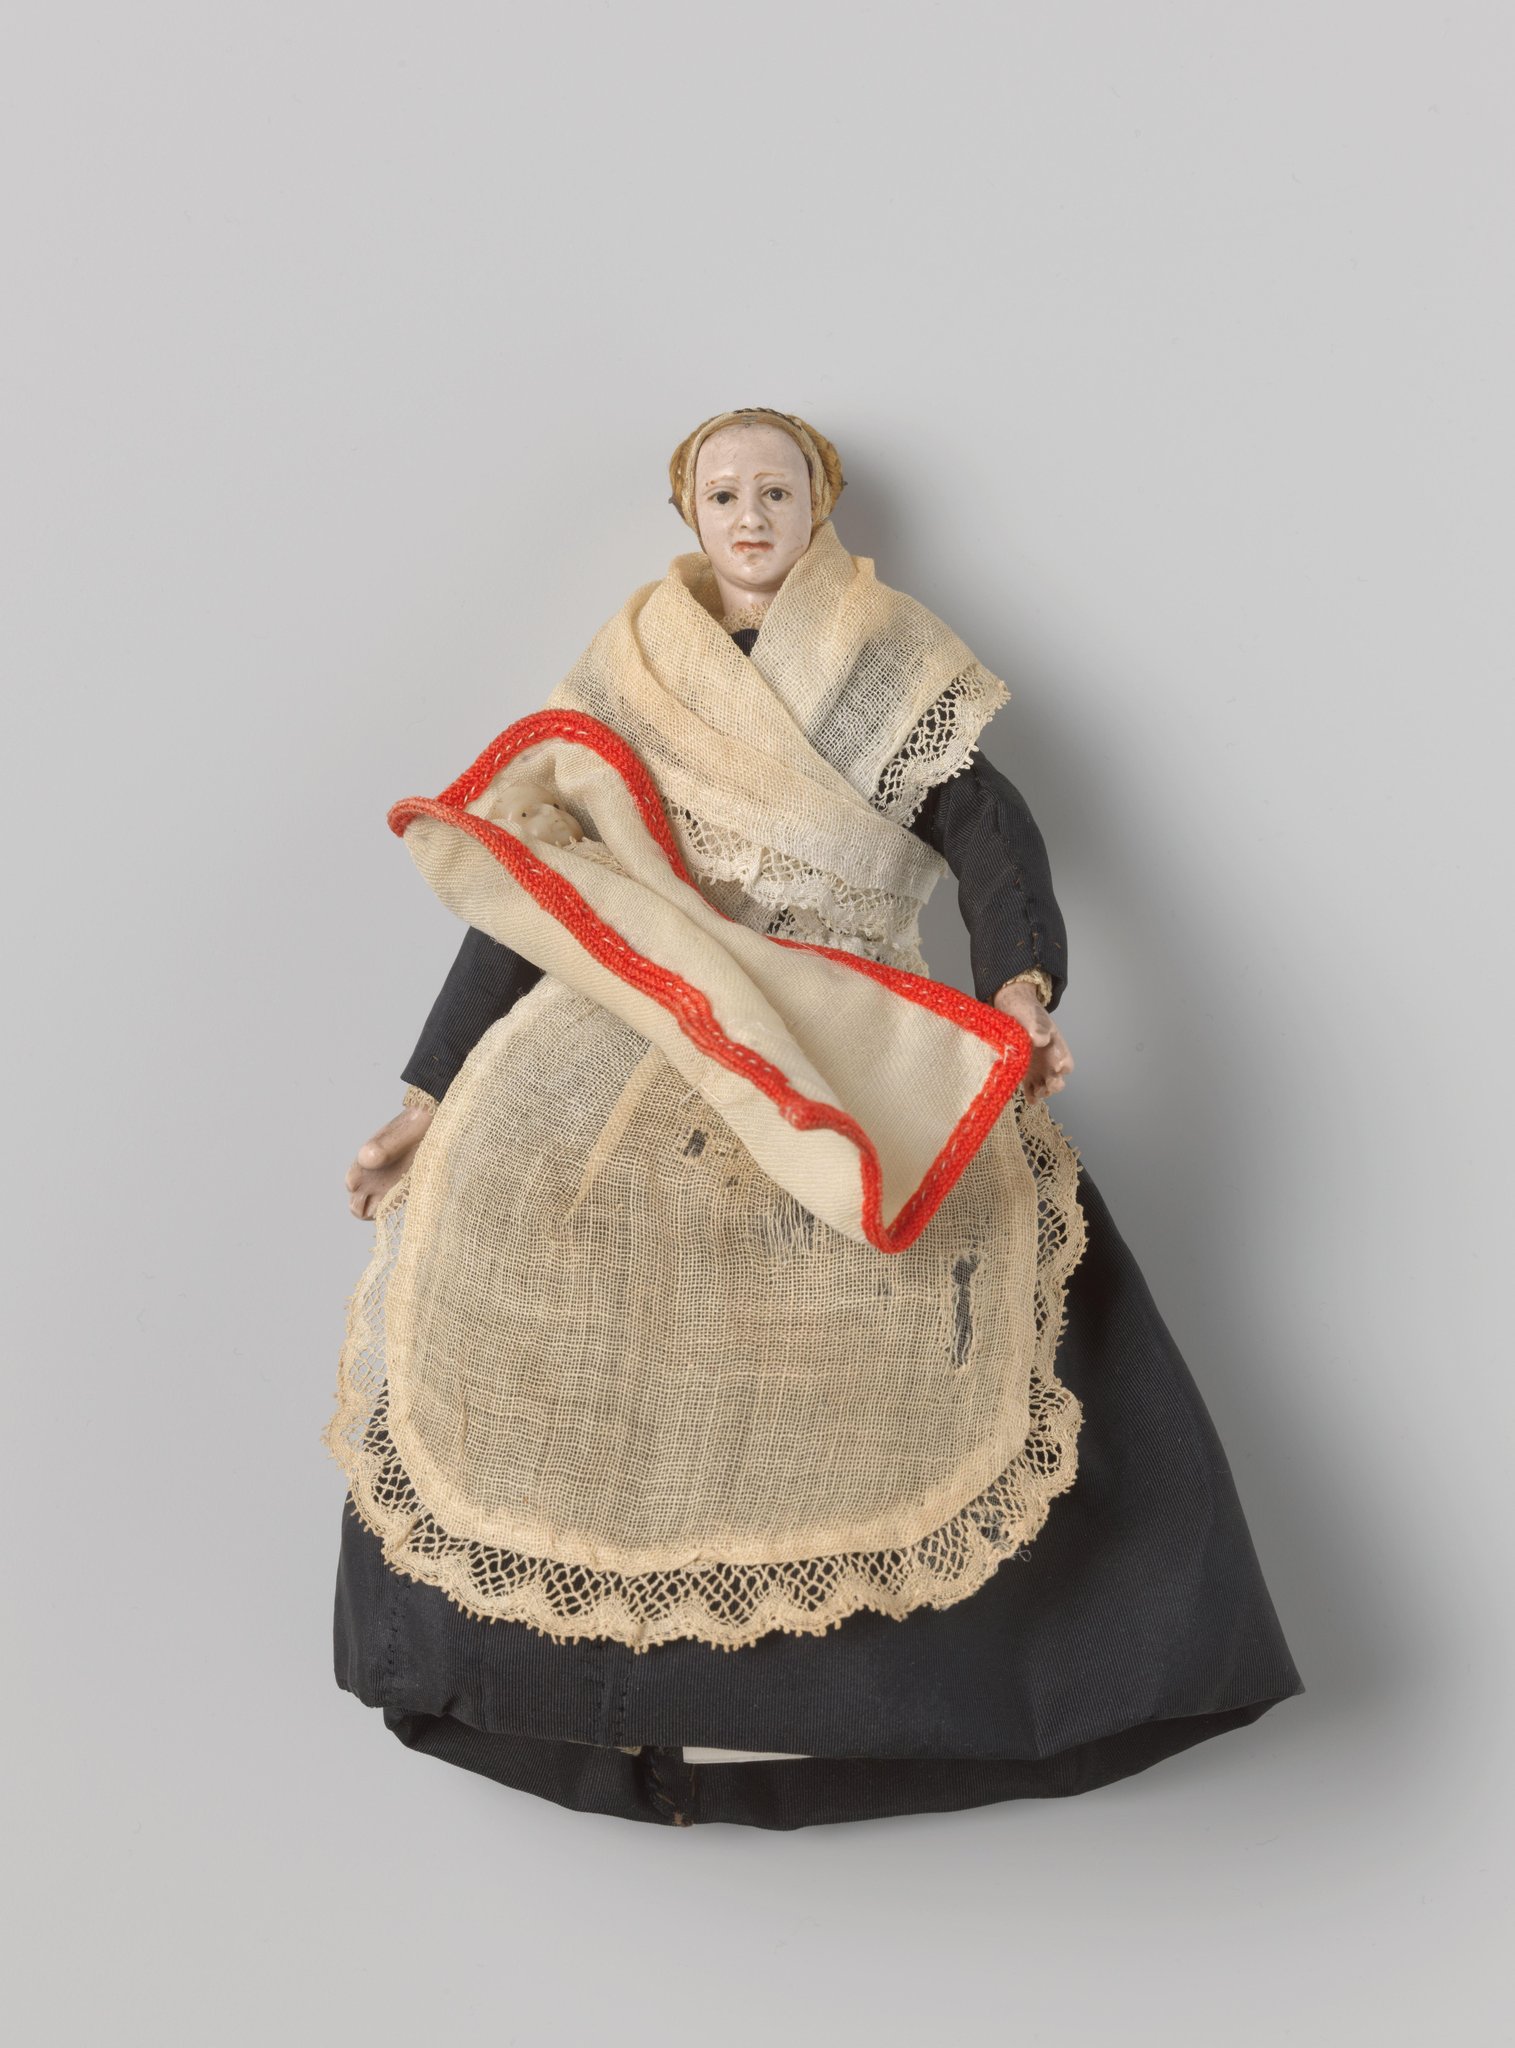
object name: doll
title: Pop, voorstellende een kind in een wikkelkleed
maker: Anonymous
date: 1700-1799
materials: linen, wax, wool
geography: amsterdam